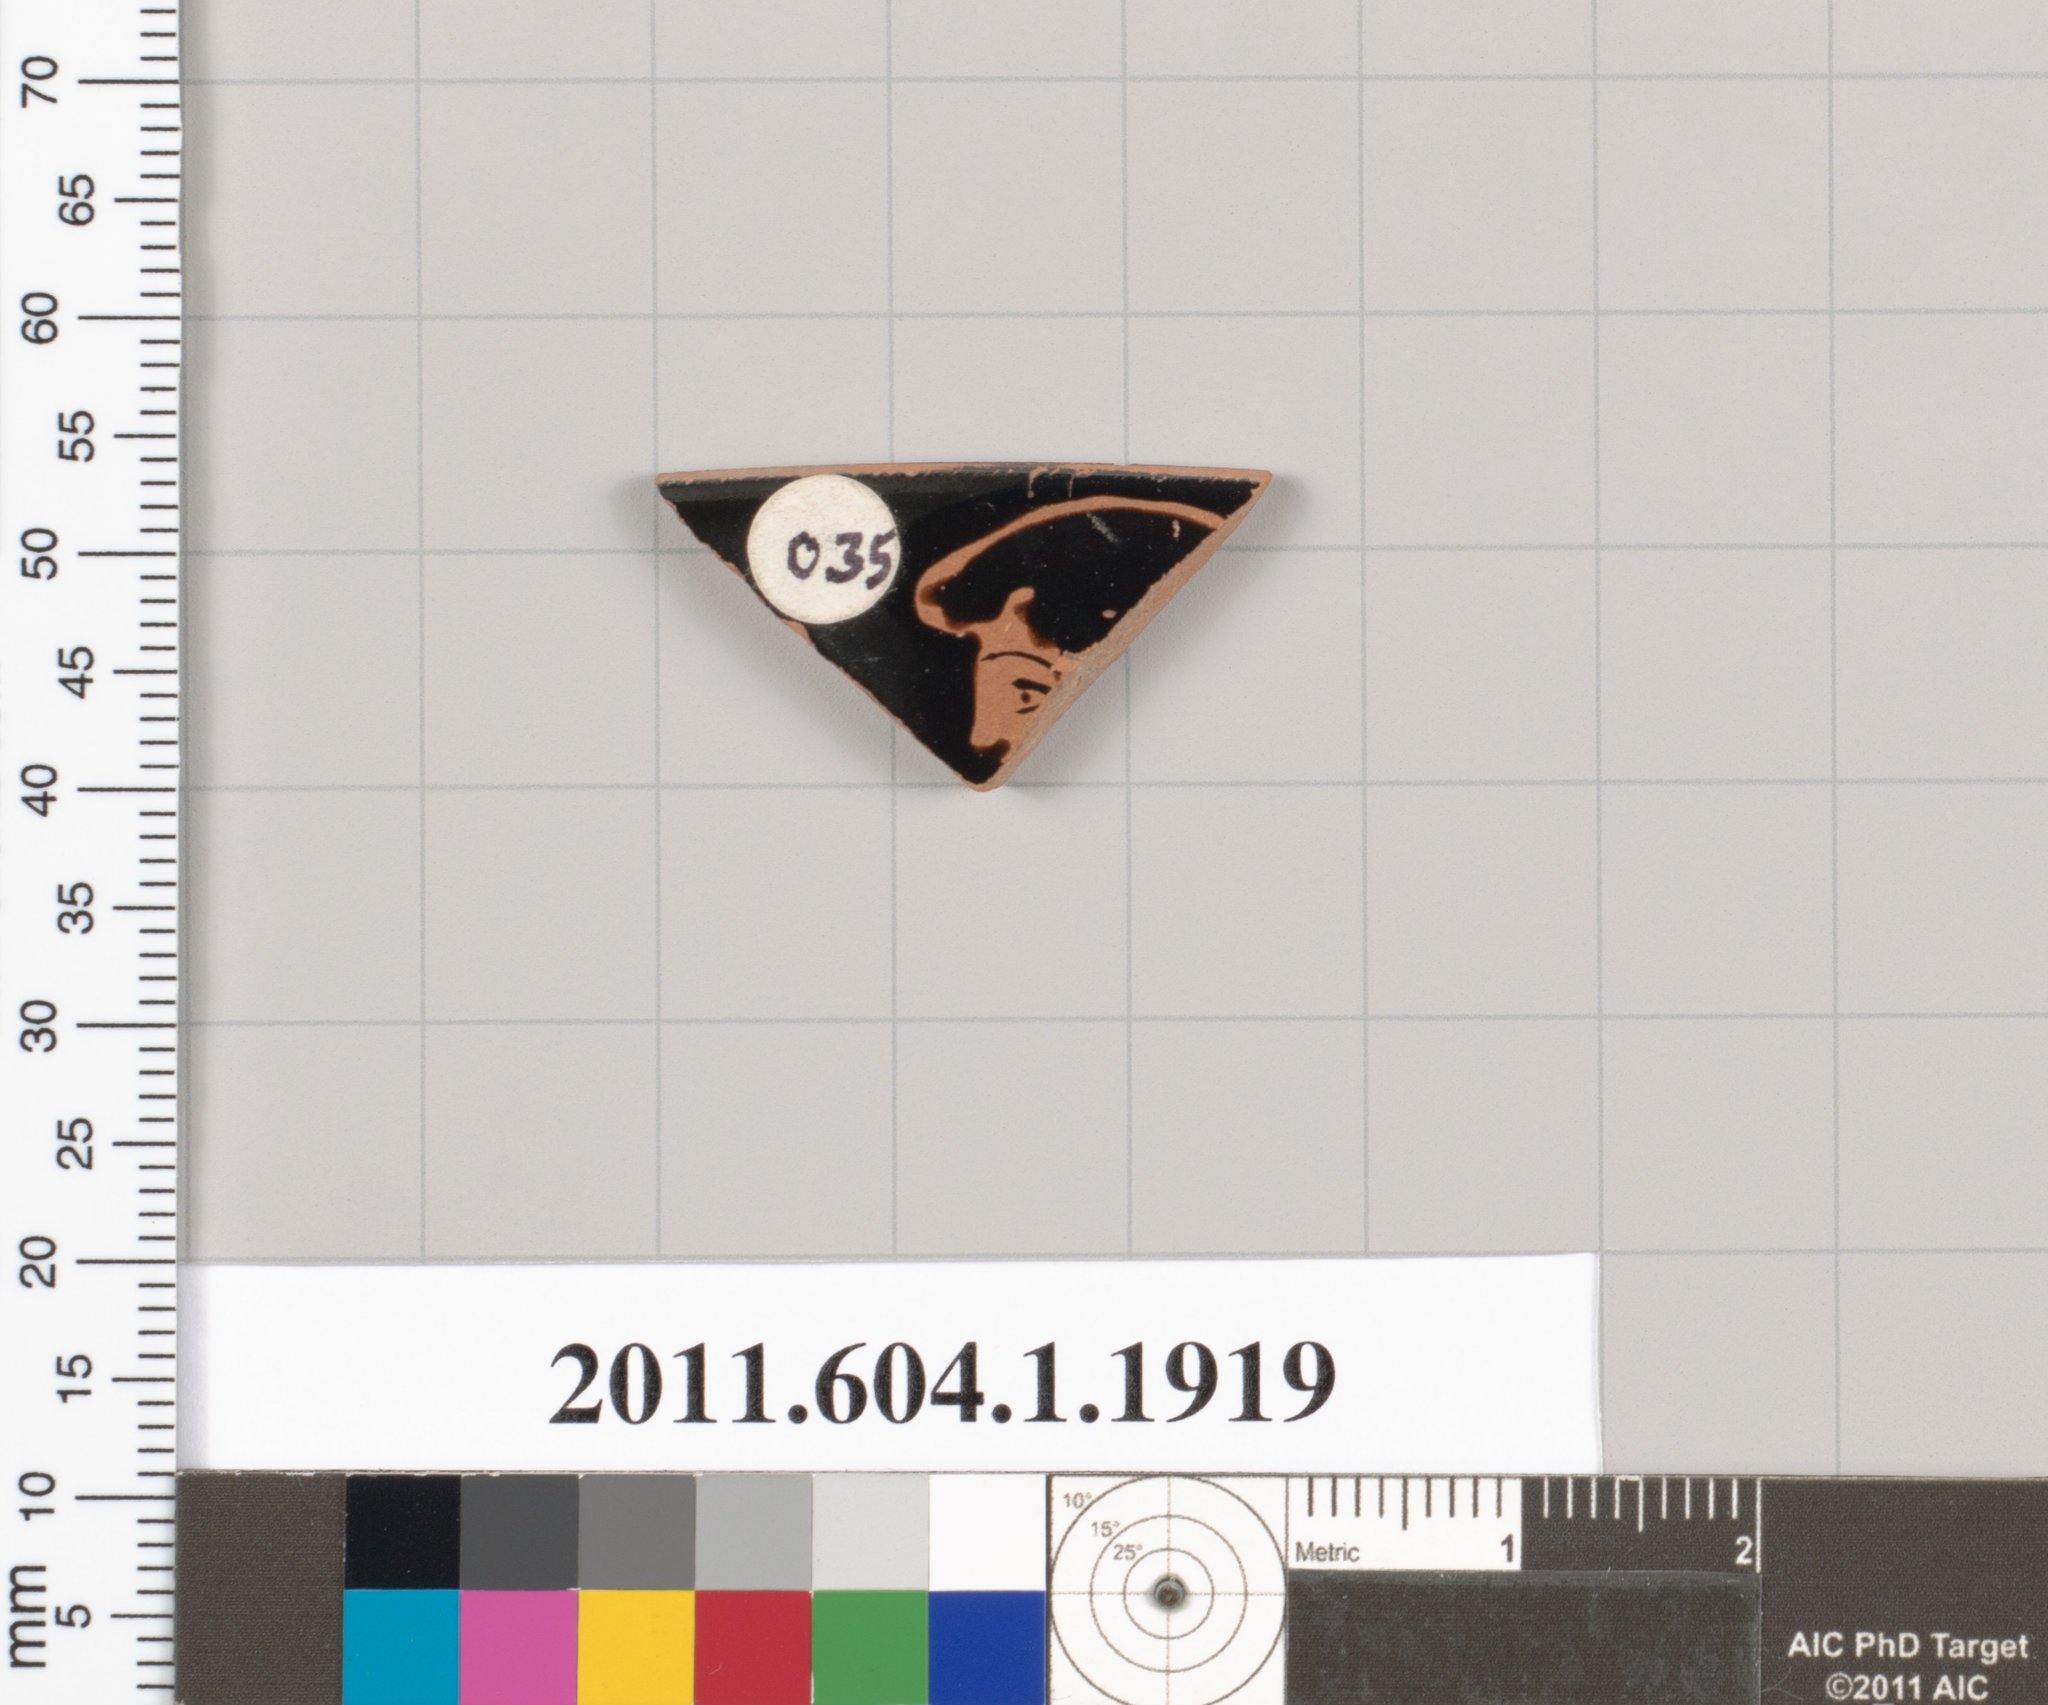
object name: kylix fragment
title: Terracotta rim fragment of a kylix (drinking cup)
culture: greek, attic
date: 475-451 BCE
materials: terracotta